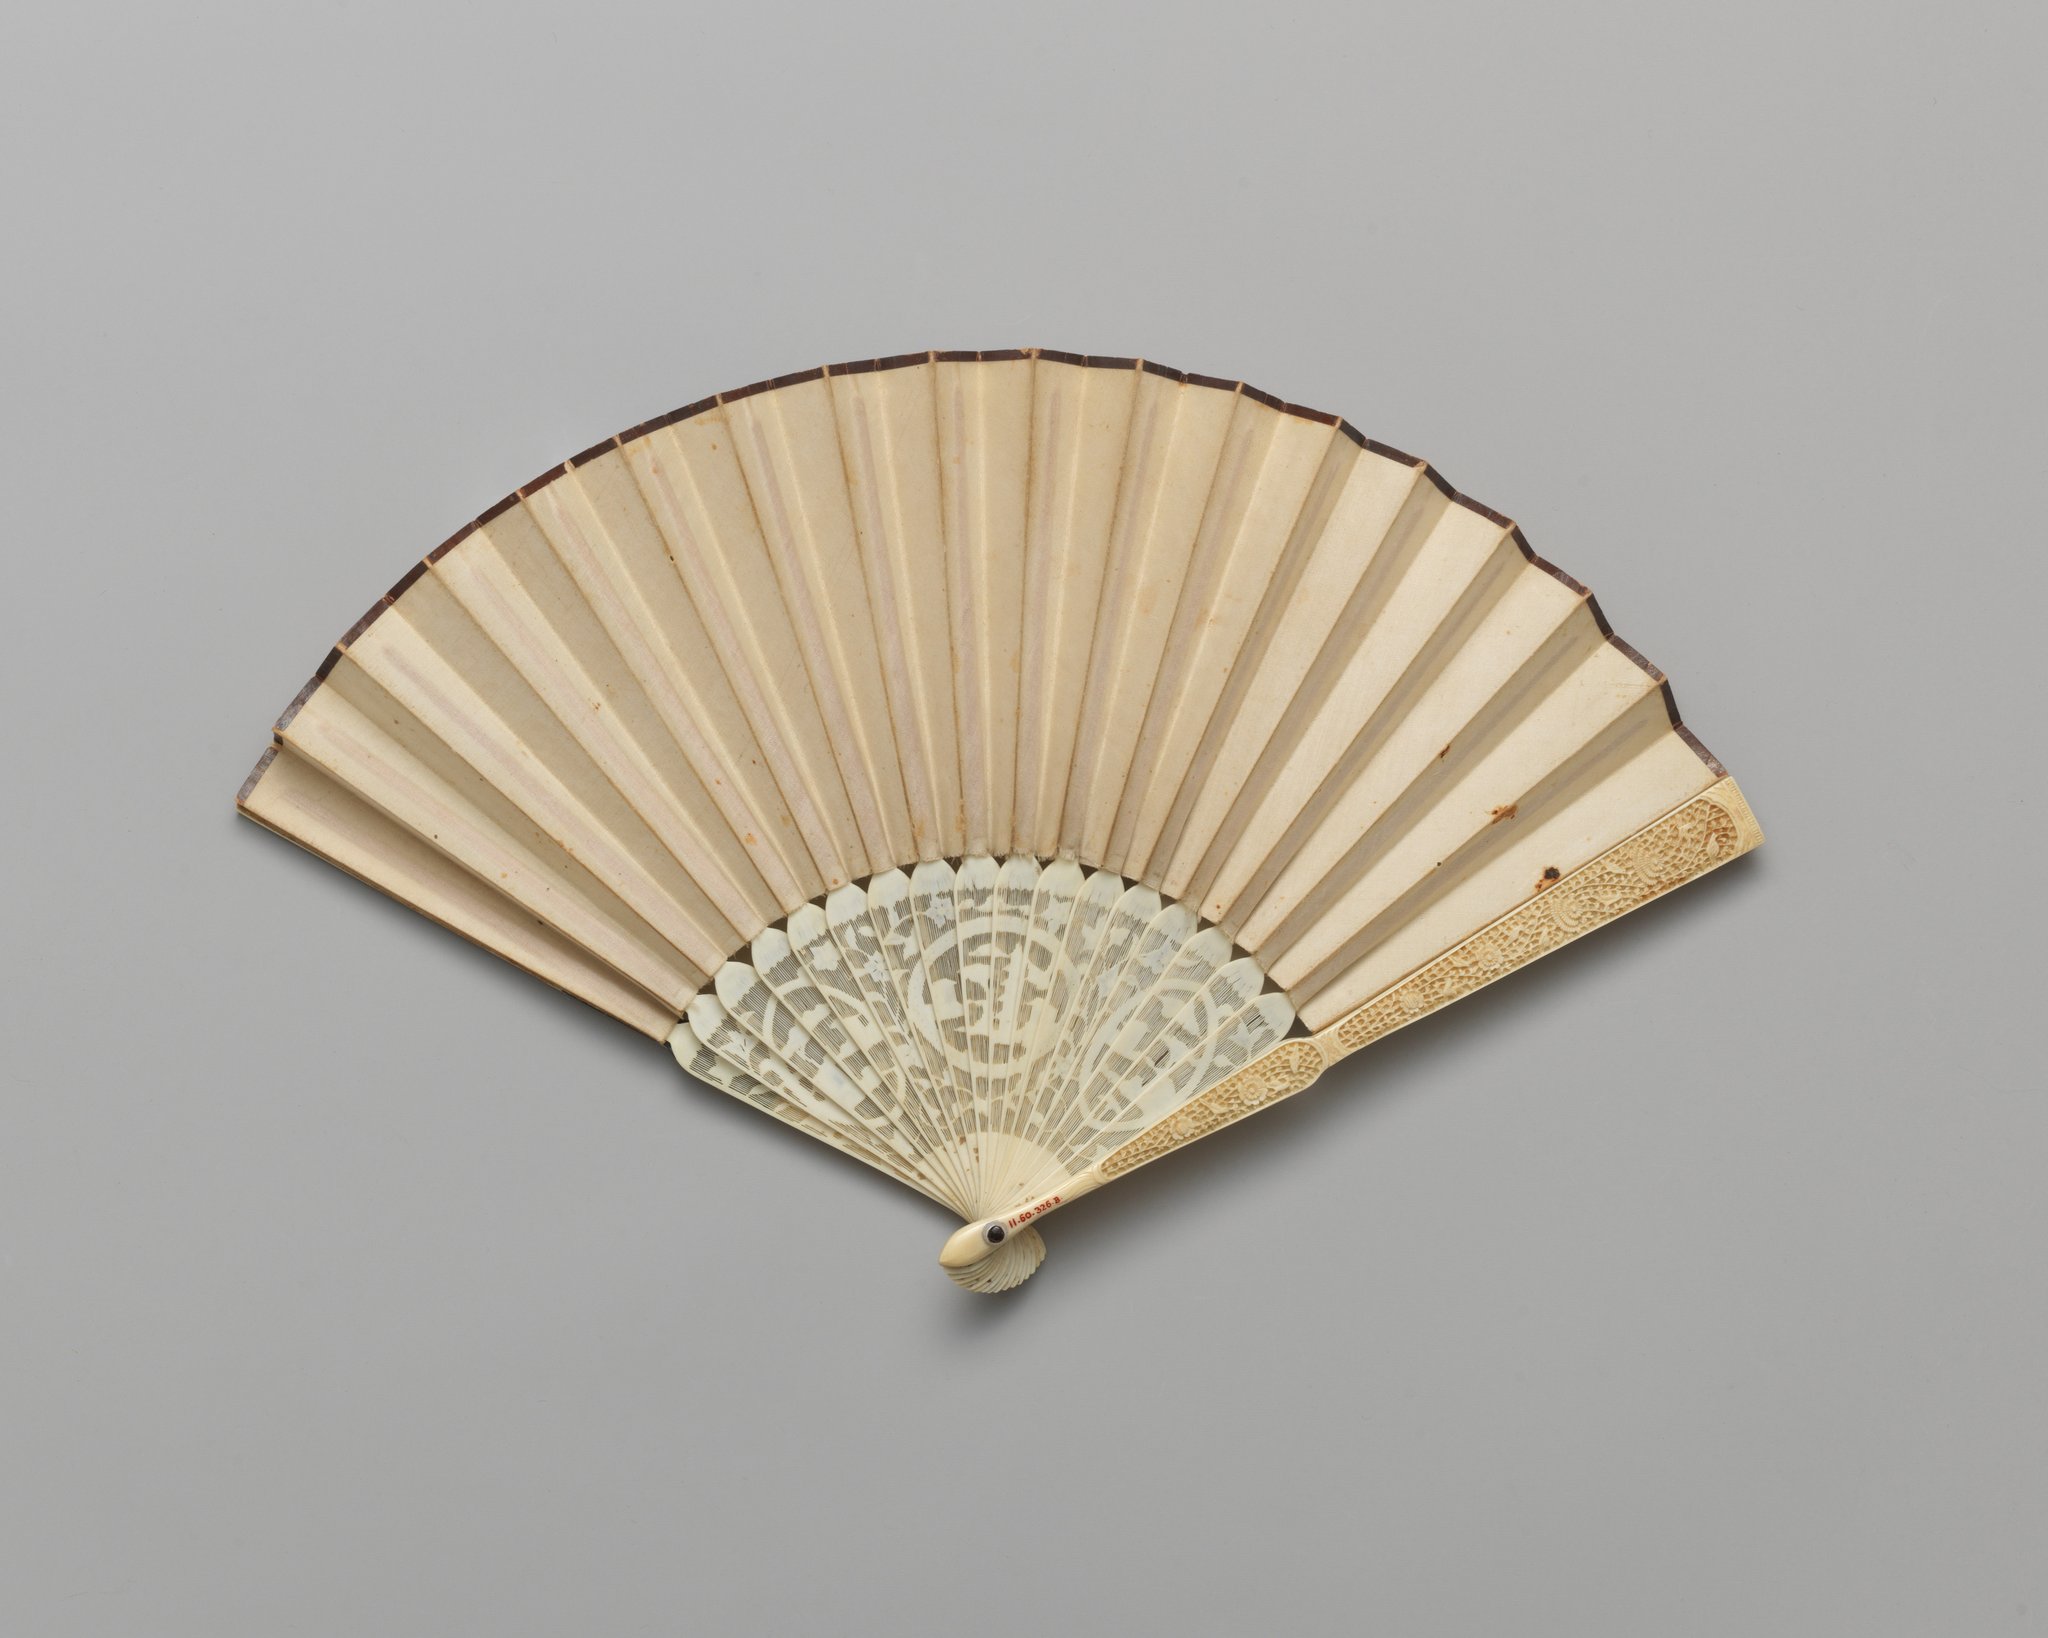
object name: fan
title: Folding Fan with Blank Leaf, and Carved Ivory Sticks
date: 1801-1900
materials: ivory, paper